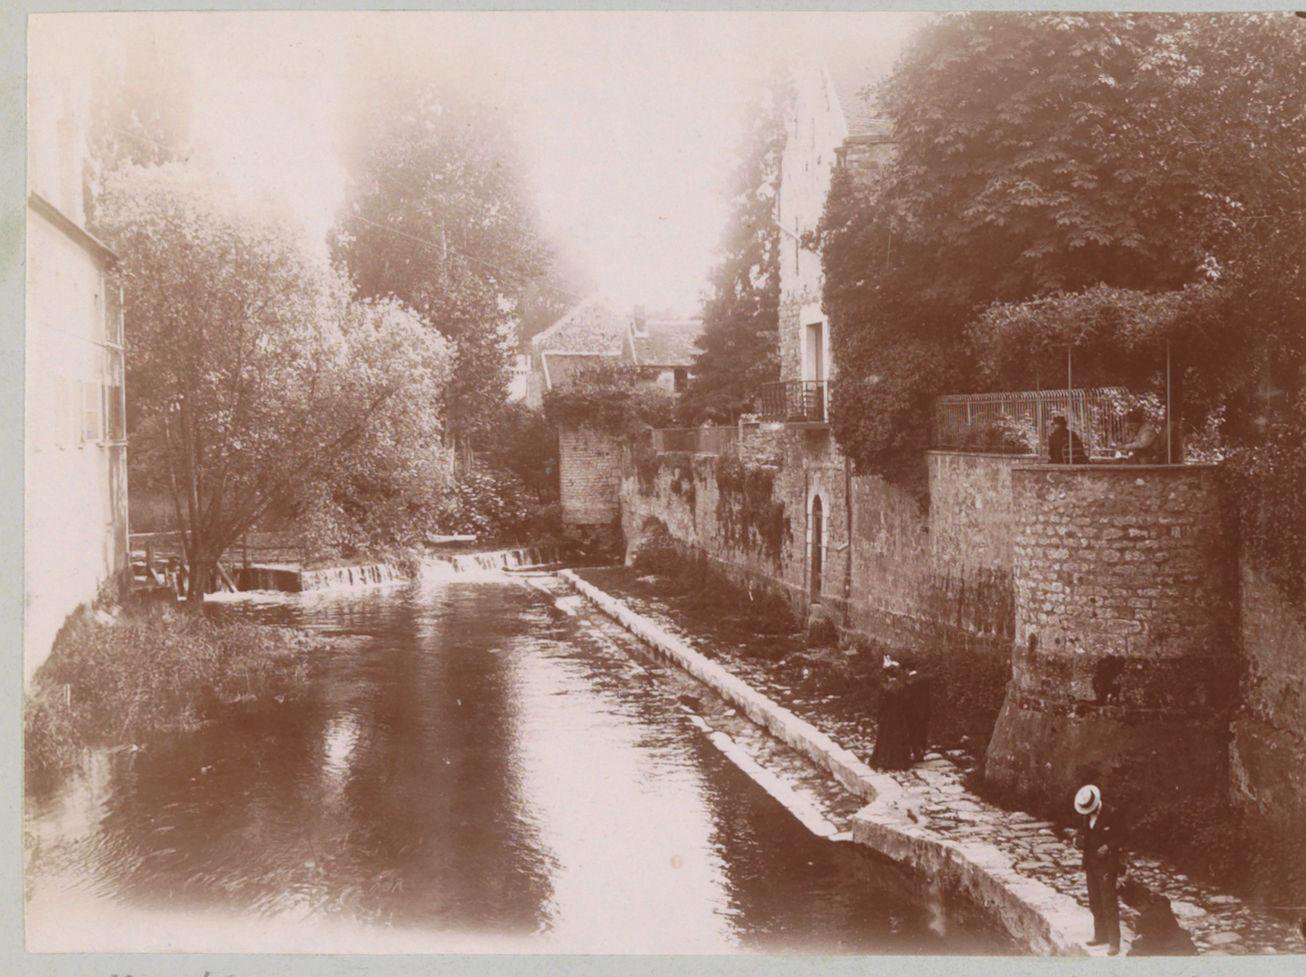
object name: photograph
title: Gezicht op de rivier en oevers in Moret-sur-Loing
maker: delizy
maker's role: manufacturer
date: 1897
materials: paper, photographic support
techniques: gelatin silver print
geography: moret-sur-loing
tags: river, river bank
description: Onderdeel van Fotoalbum van een Franse amateurfotograaf met opnames van uitstapjes in Frankrijk, Spanje, België, Luxemburg en Nederland, de eerste automobielen en autoraces.